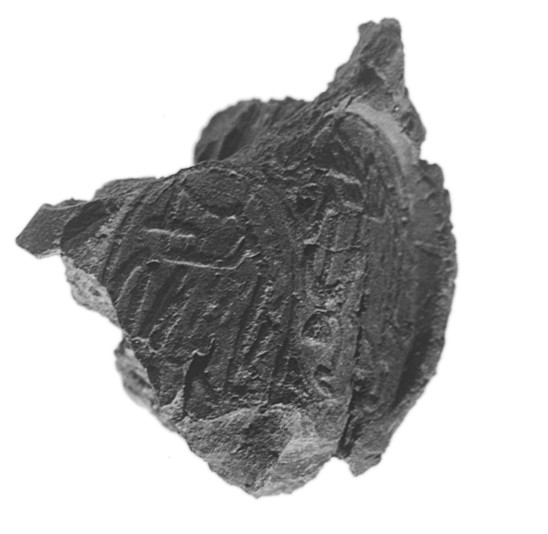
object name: sealing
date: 2030-1640 BCE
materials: clay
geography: egypt